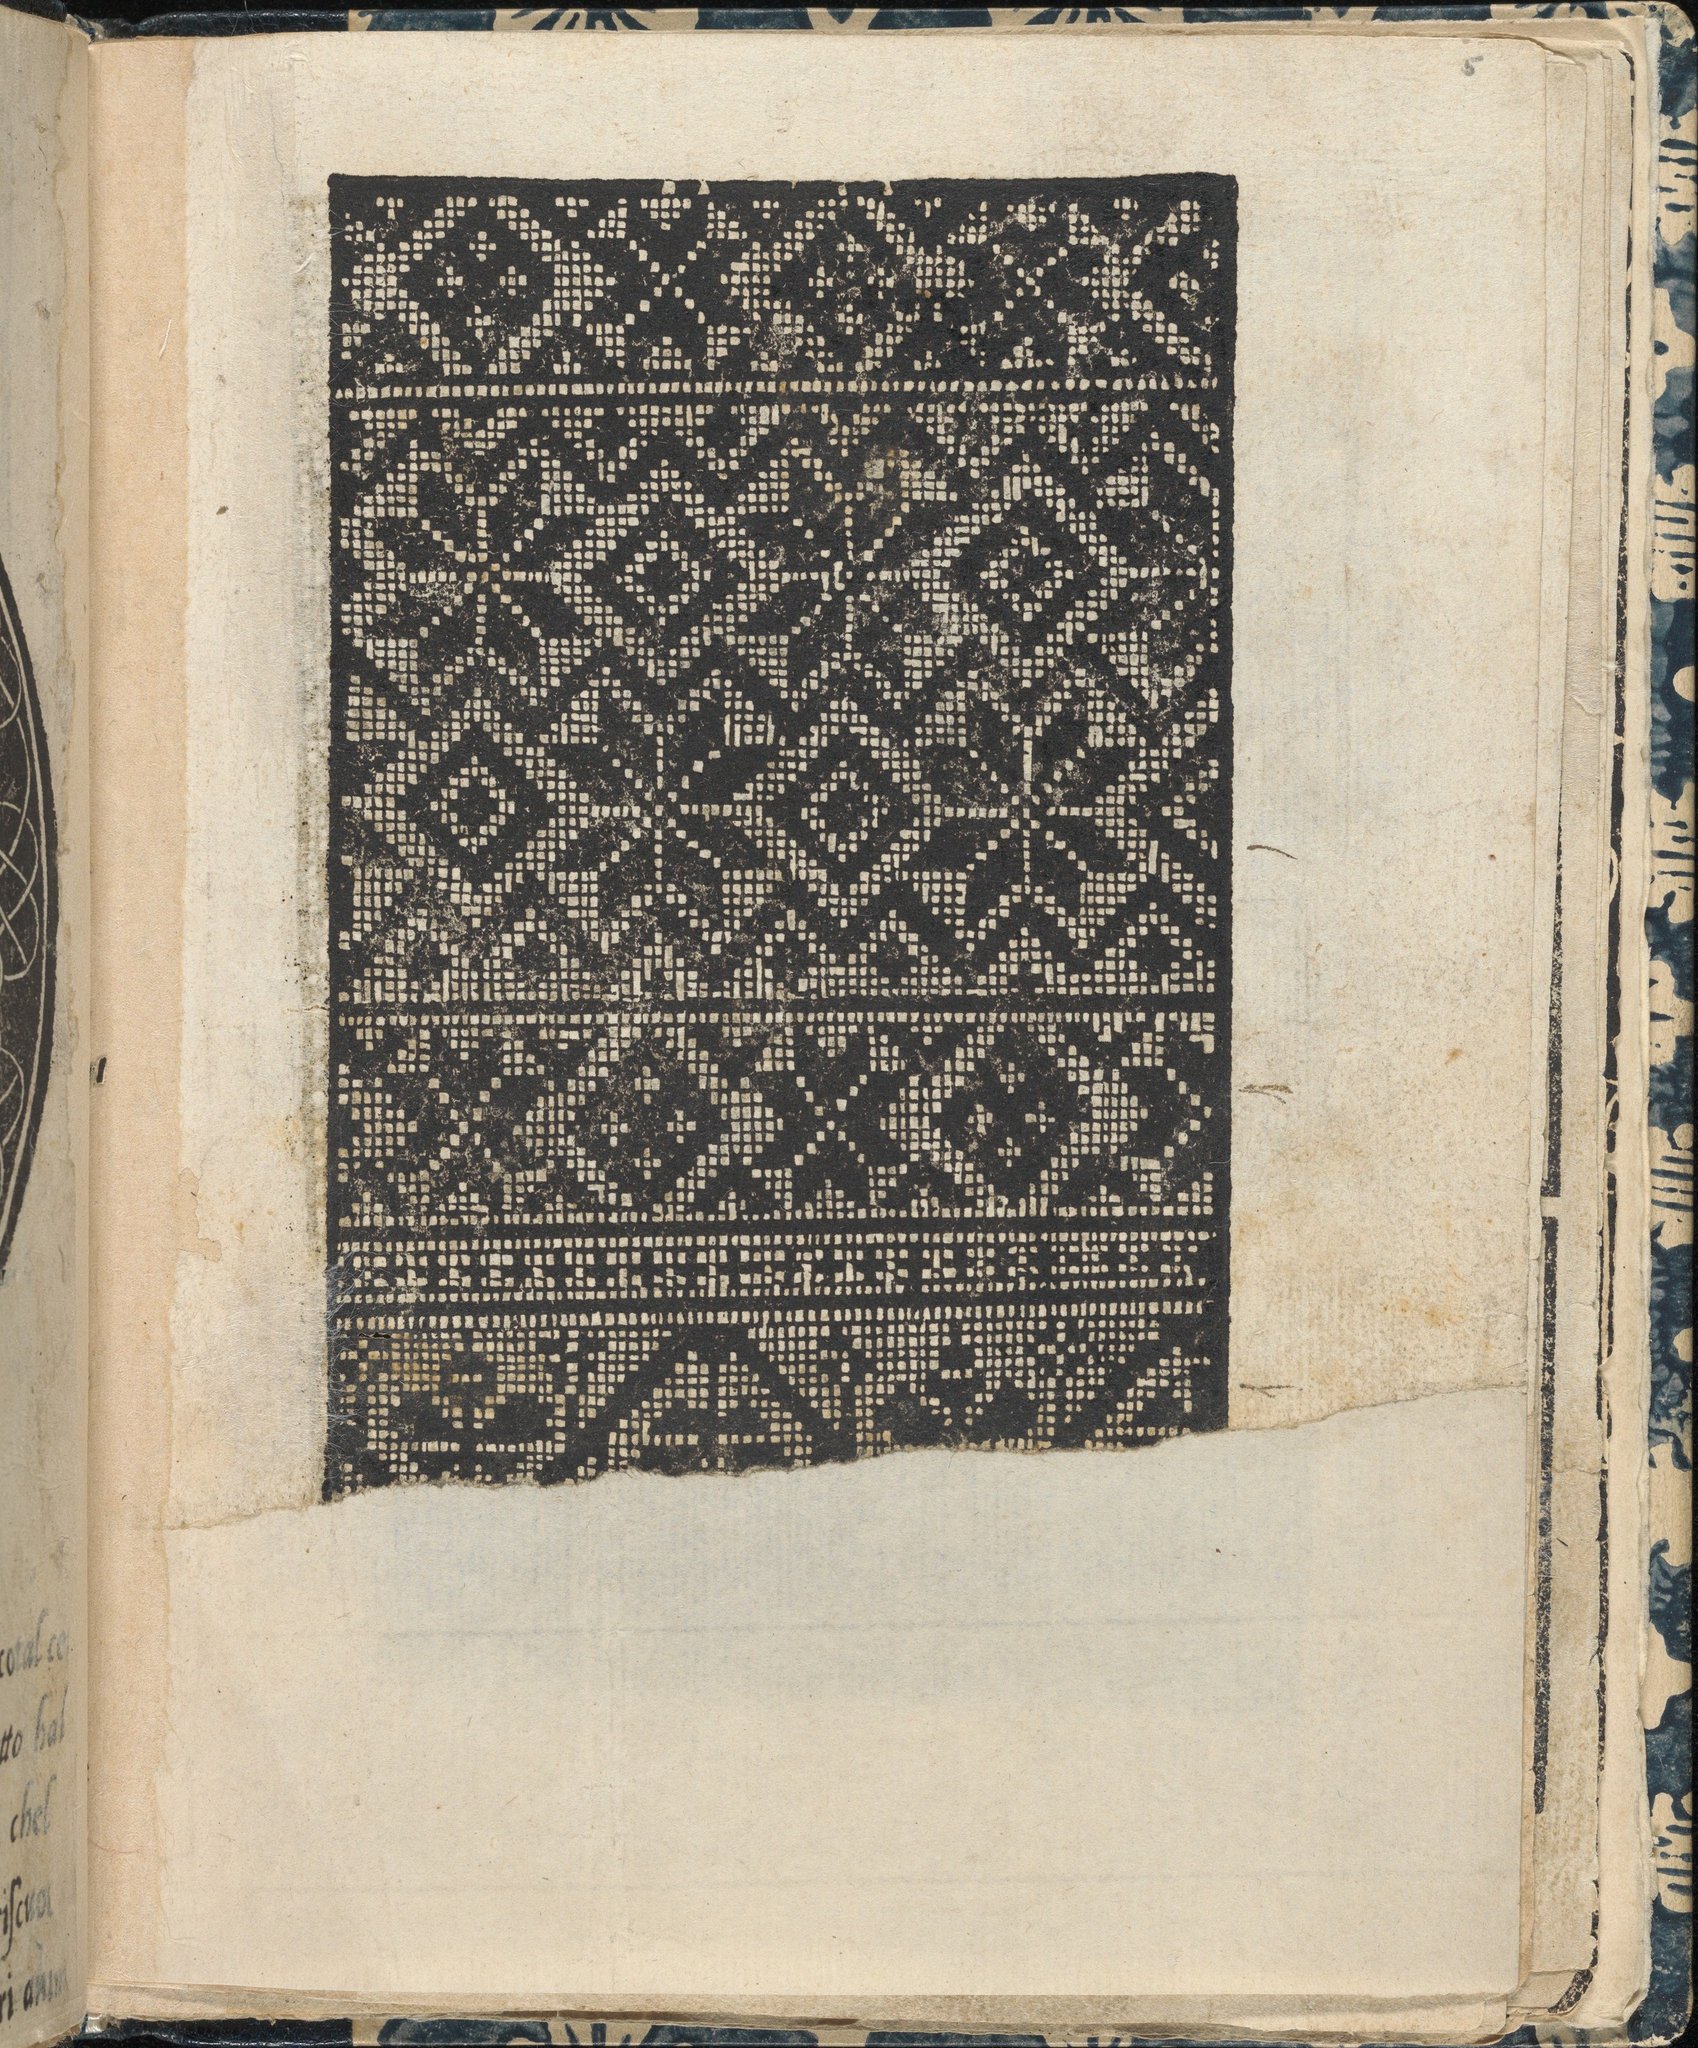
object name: book print ornament architecture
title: Essempio di recammi, page 5 (recto)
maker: giovanni antonio tagliente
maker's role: author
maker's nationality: italian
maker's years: 1465-1528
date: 1530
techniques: woodcut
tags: ornament